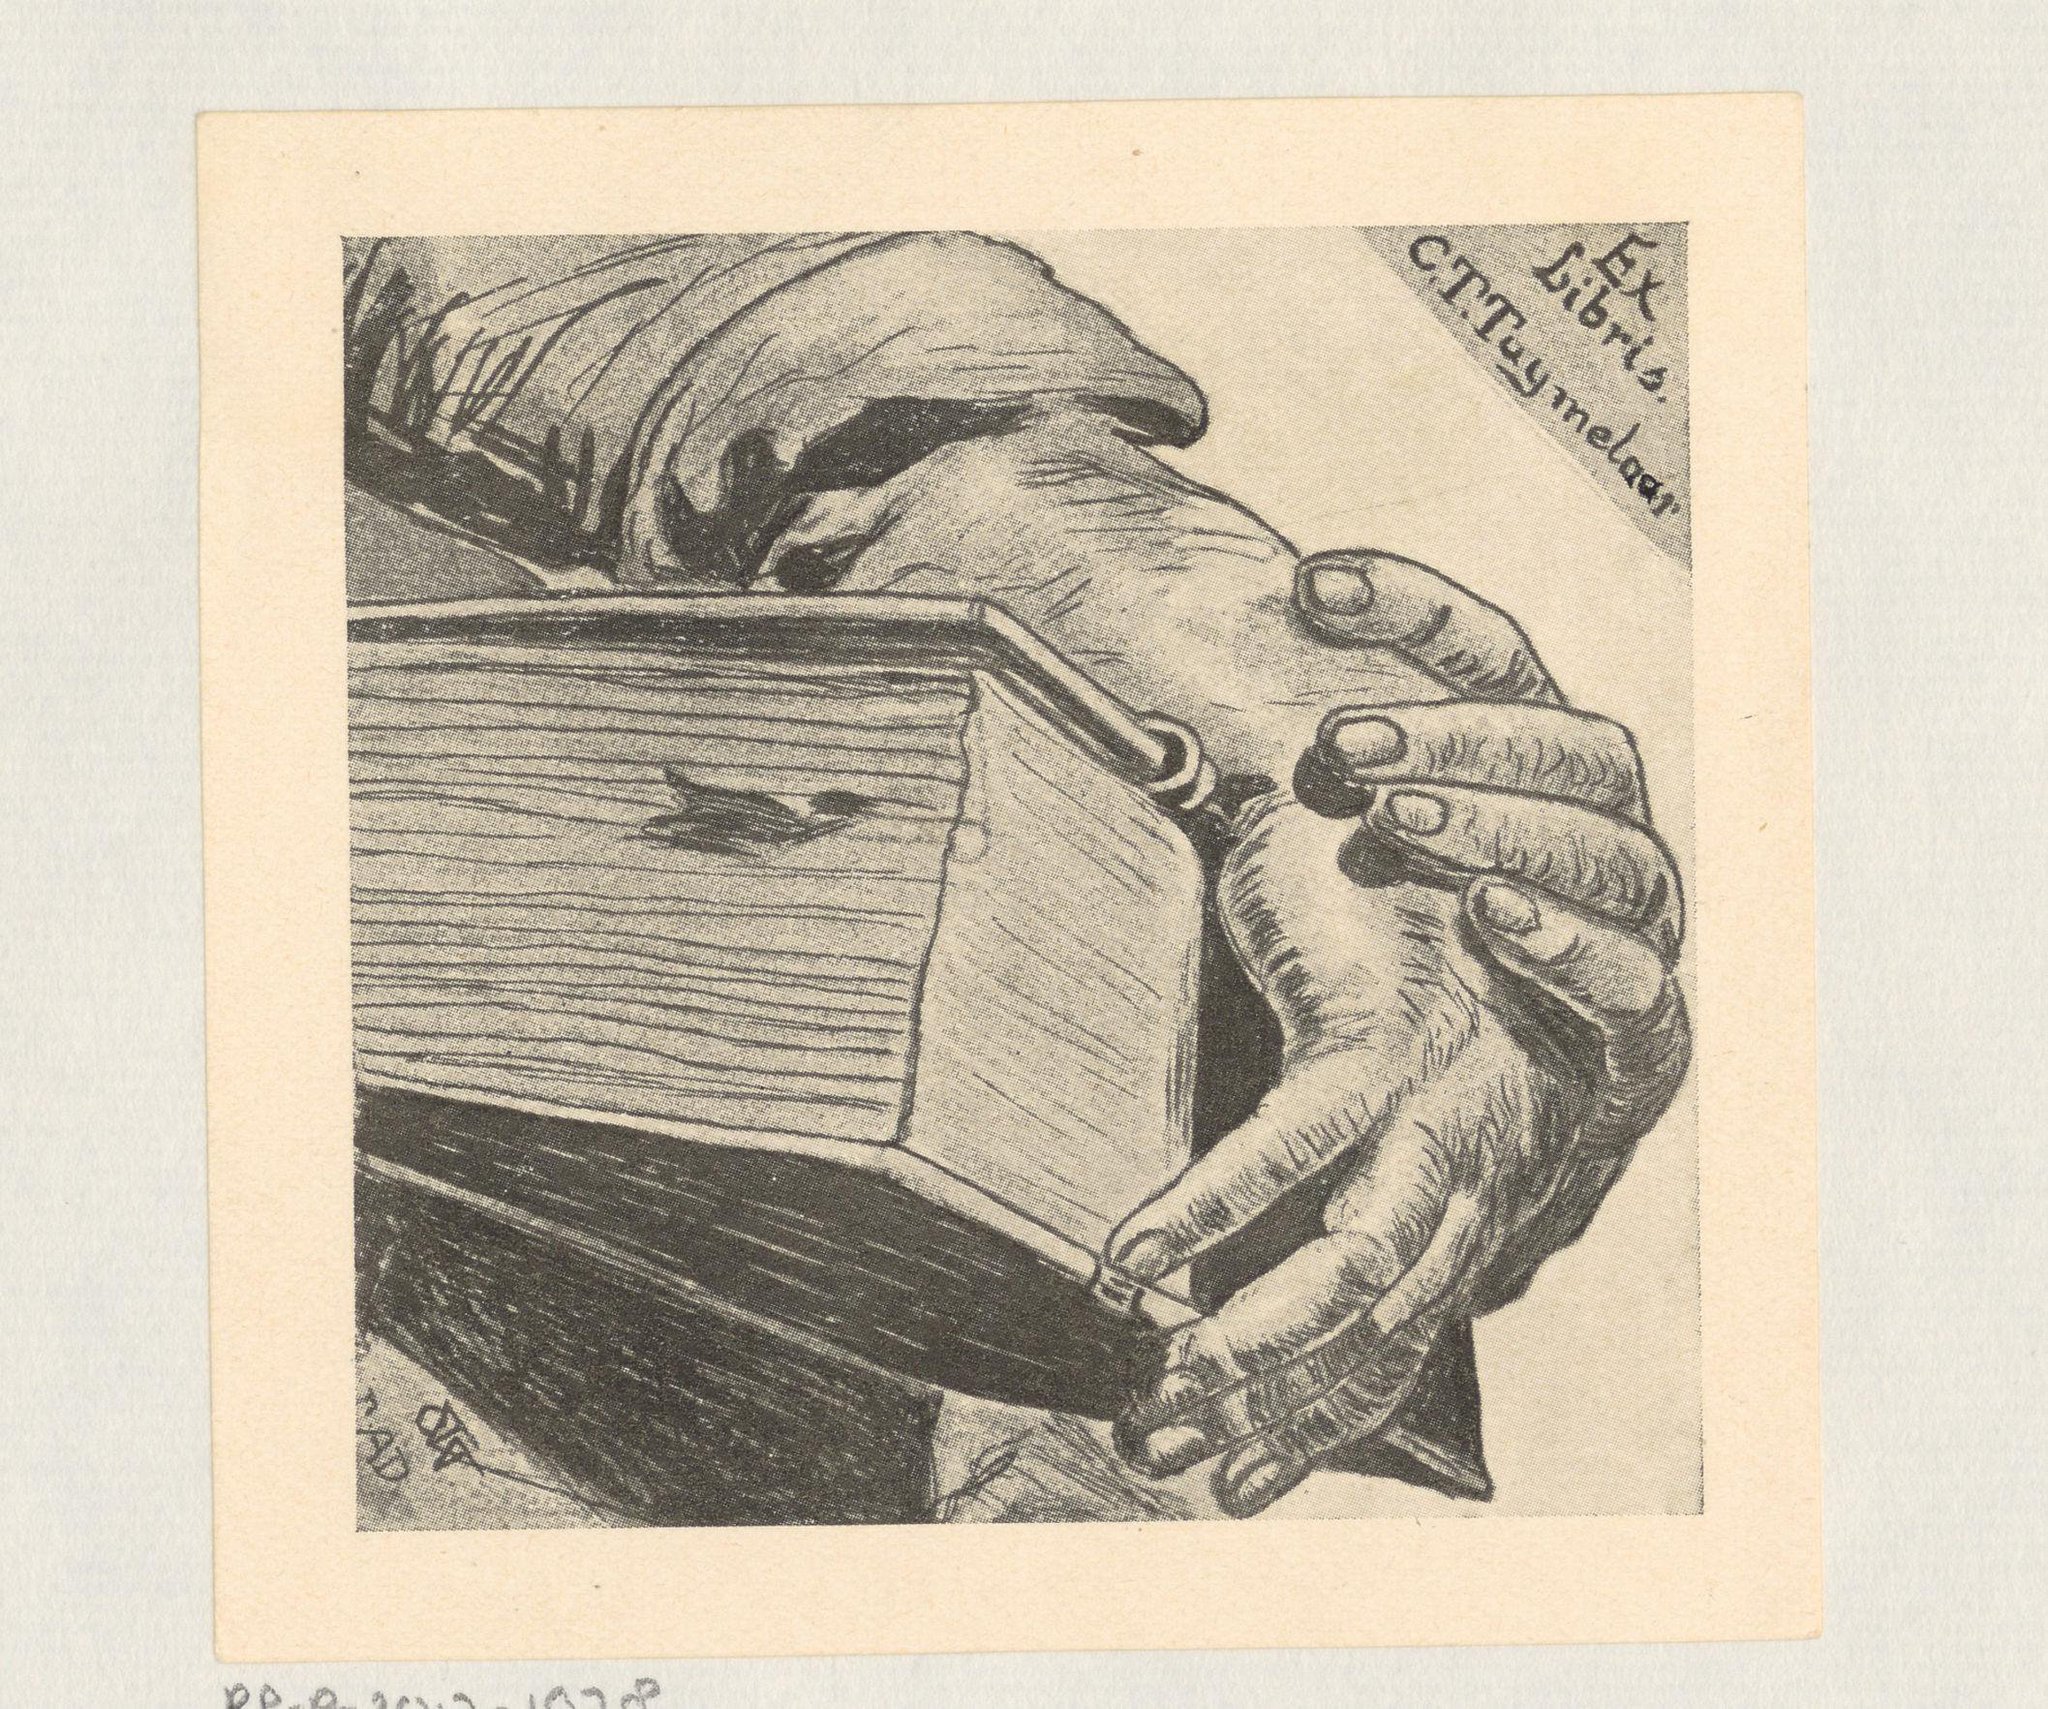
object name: photomechanical print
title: Ex libris van C.Tj. Tuymelaar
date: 1933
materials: paper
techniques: autotype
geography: netherlands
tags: print maker, c.tj. tuymelaar, sleeves, book, hands on top of each other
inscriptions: signature, date and inscription: ‘CTj Tuymelaar / cl. '33’